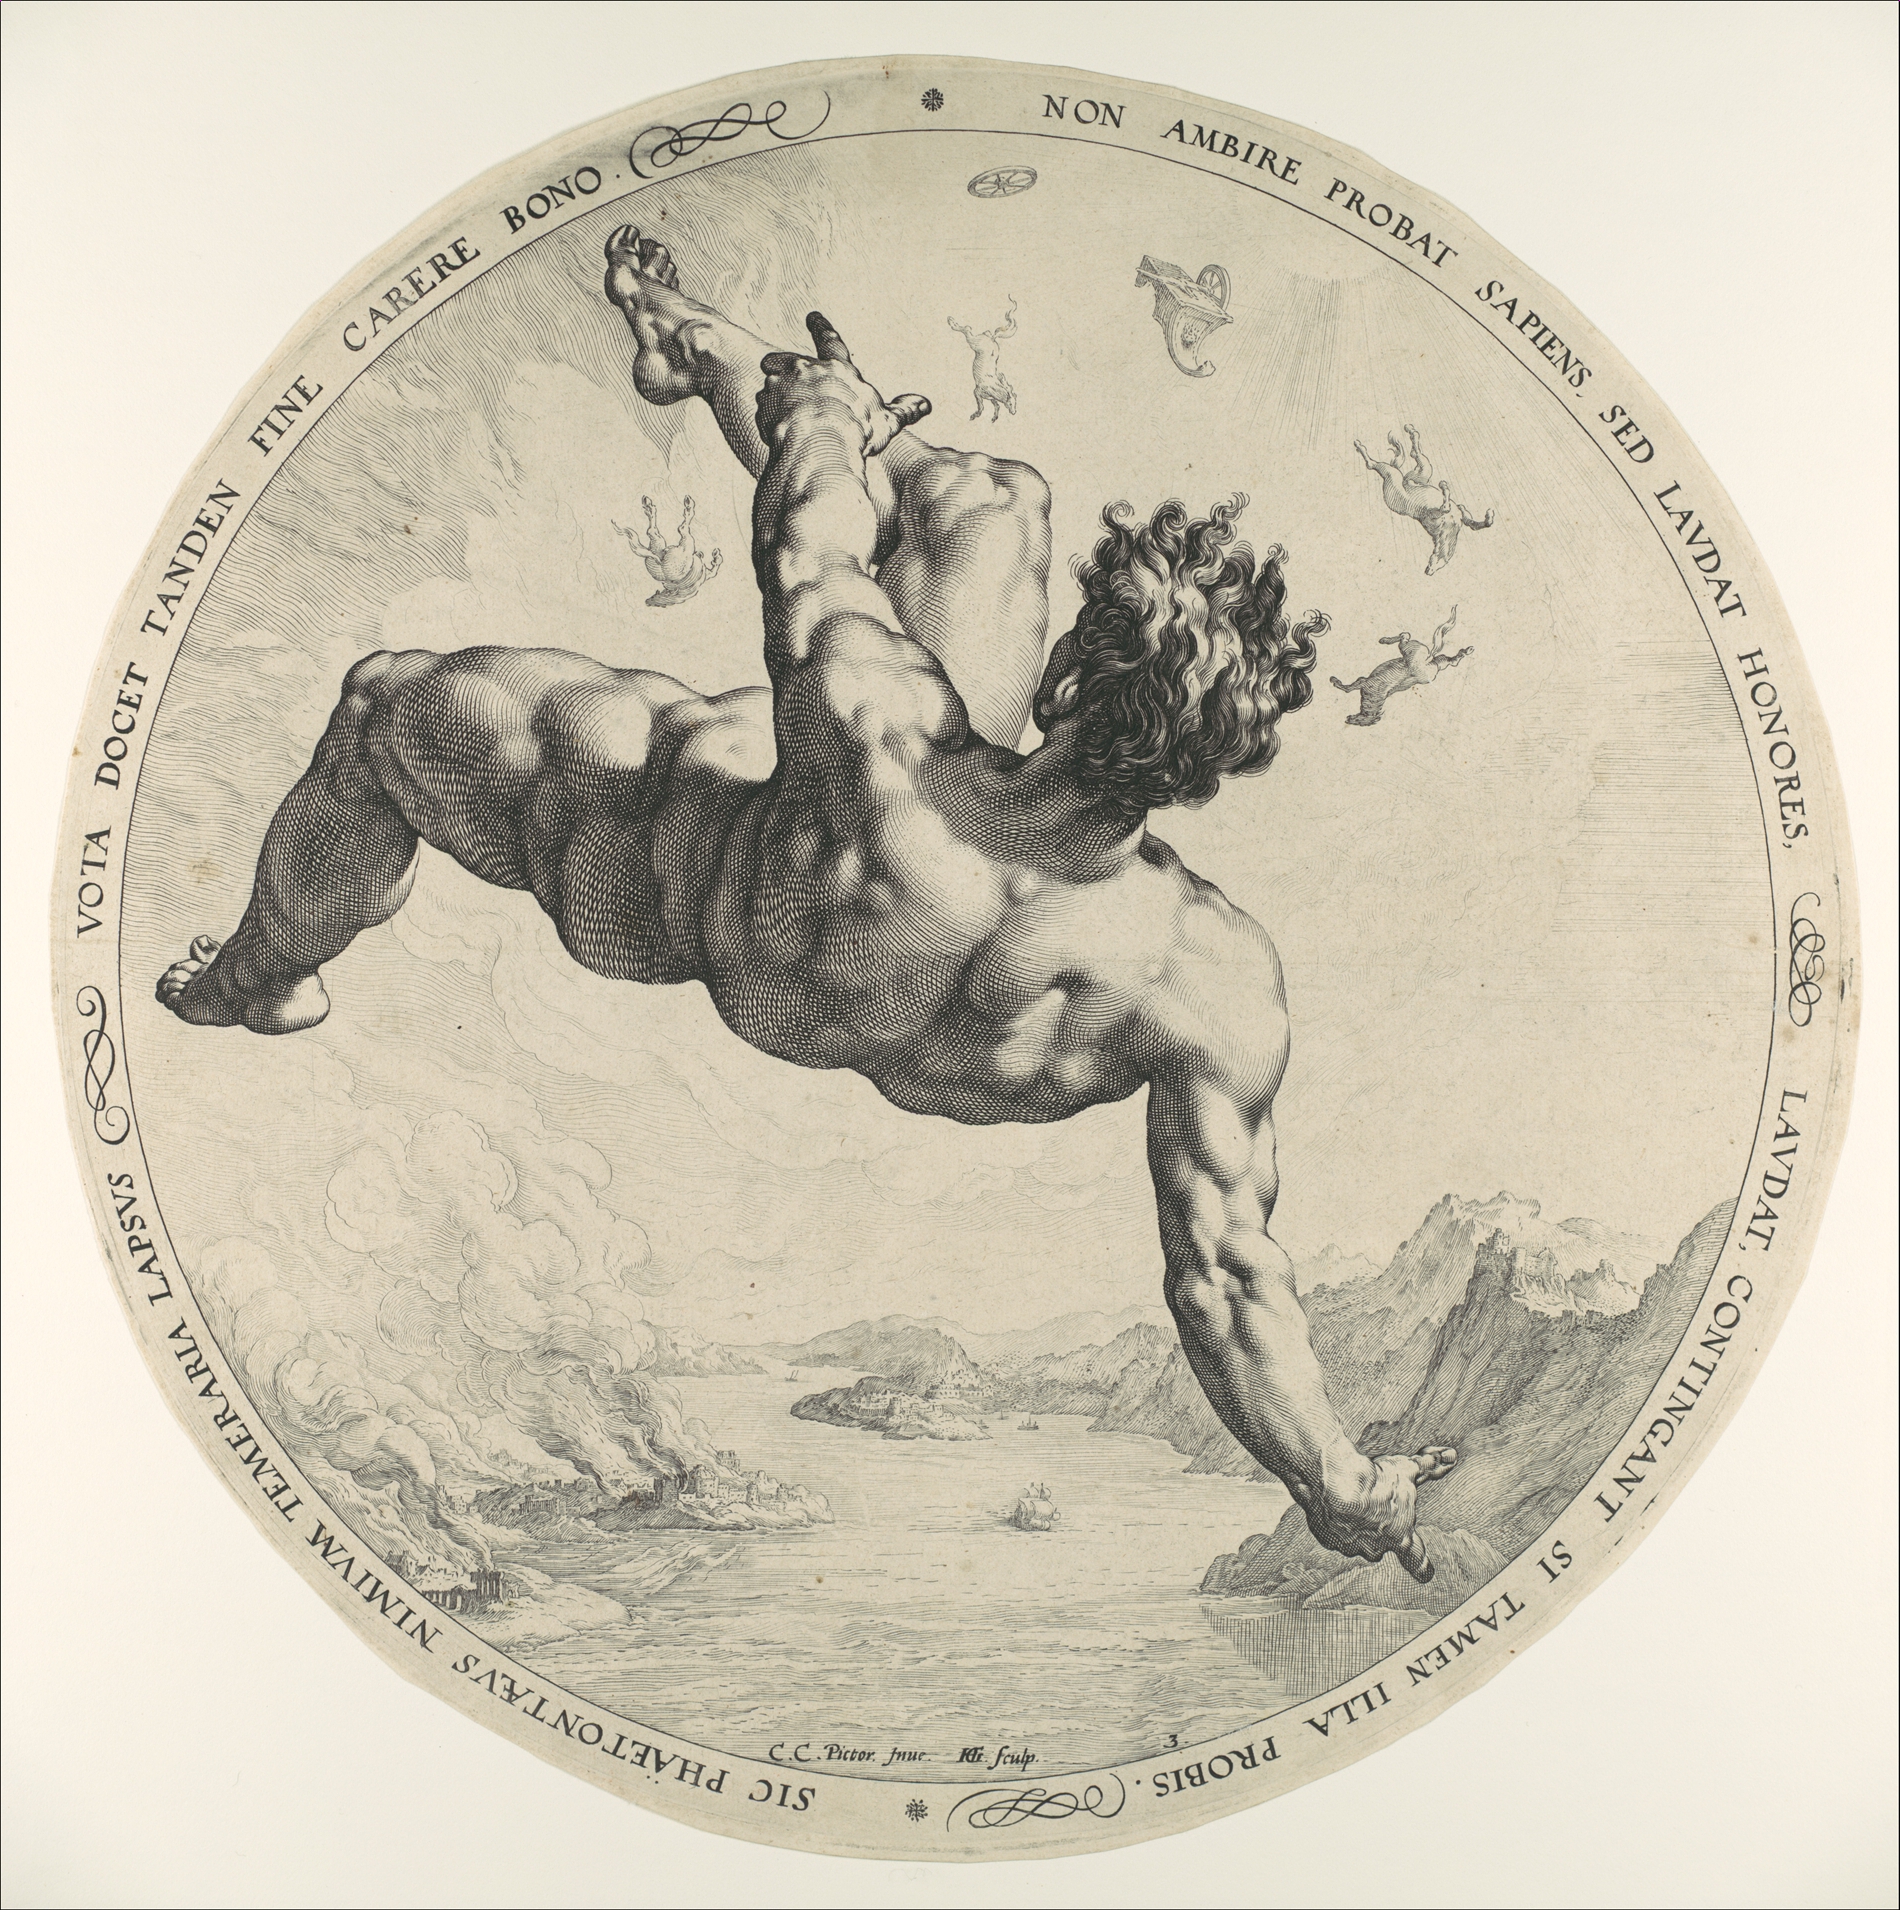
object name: print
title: Phaeton, from "The Four Disgracers"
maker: hendrick goltzius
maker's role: artist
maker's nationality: netherlandish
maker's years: 1558-1617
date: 1588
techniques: engraving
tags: male nudes,horses